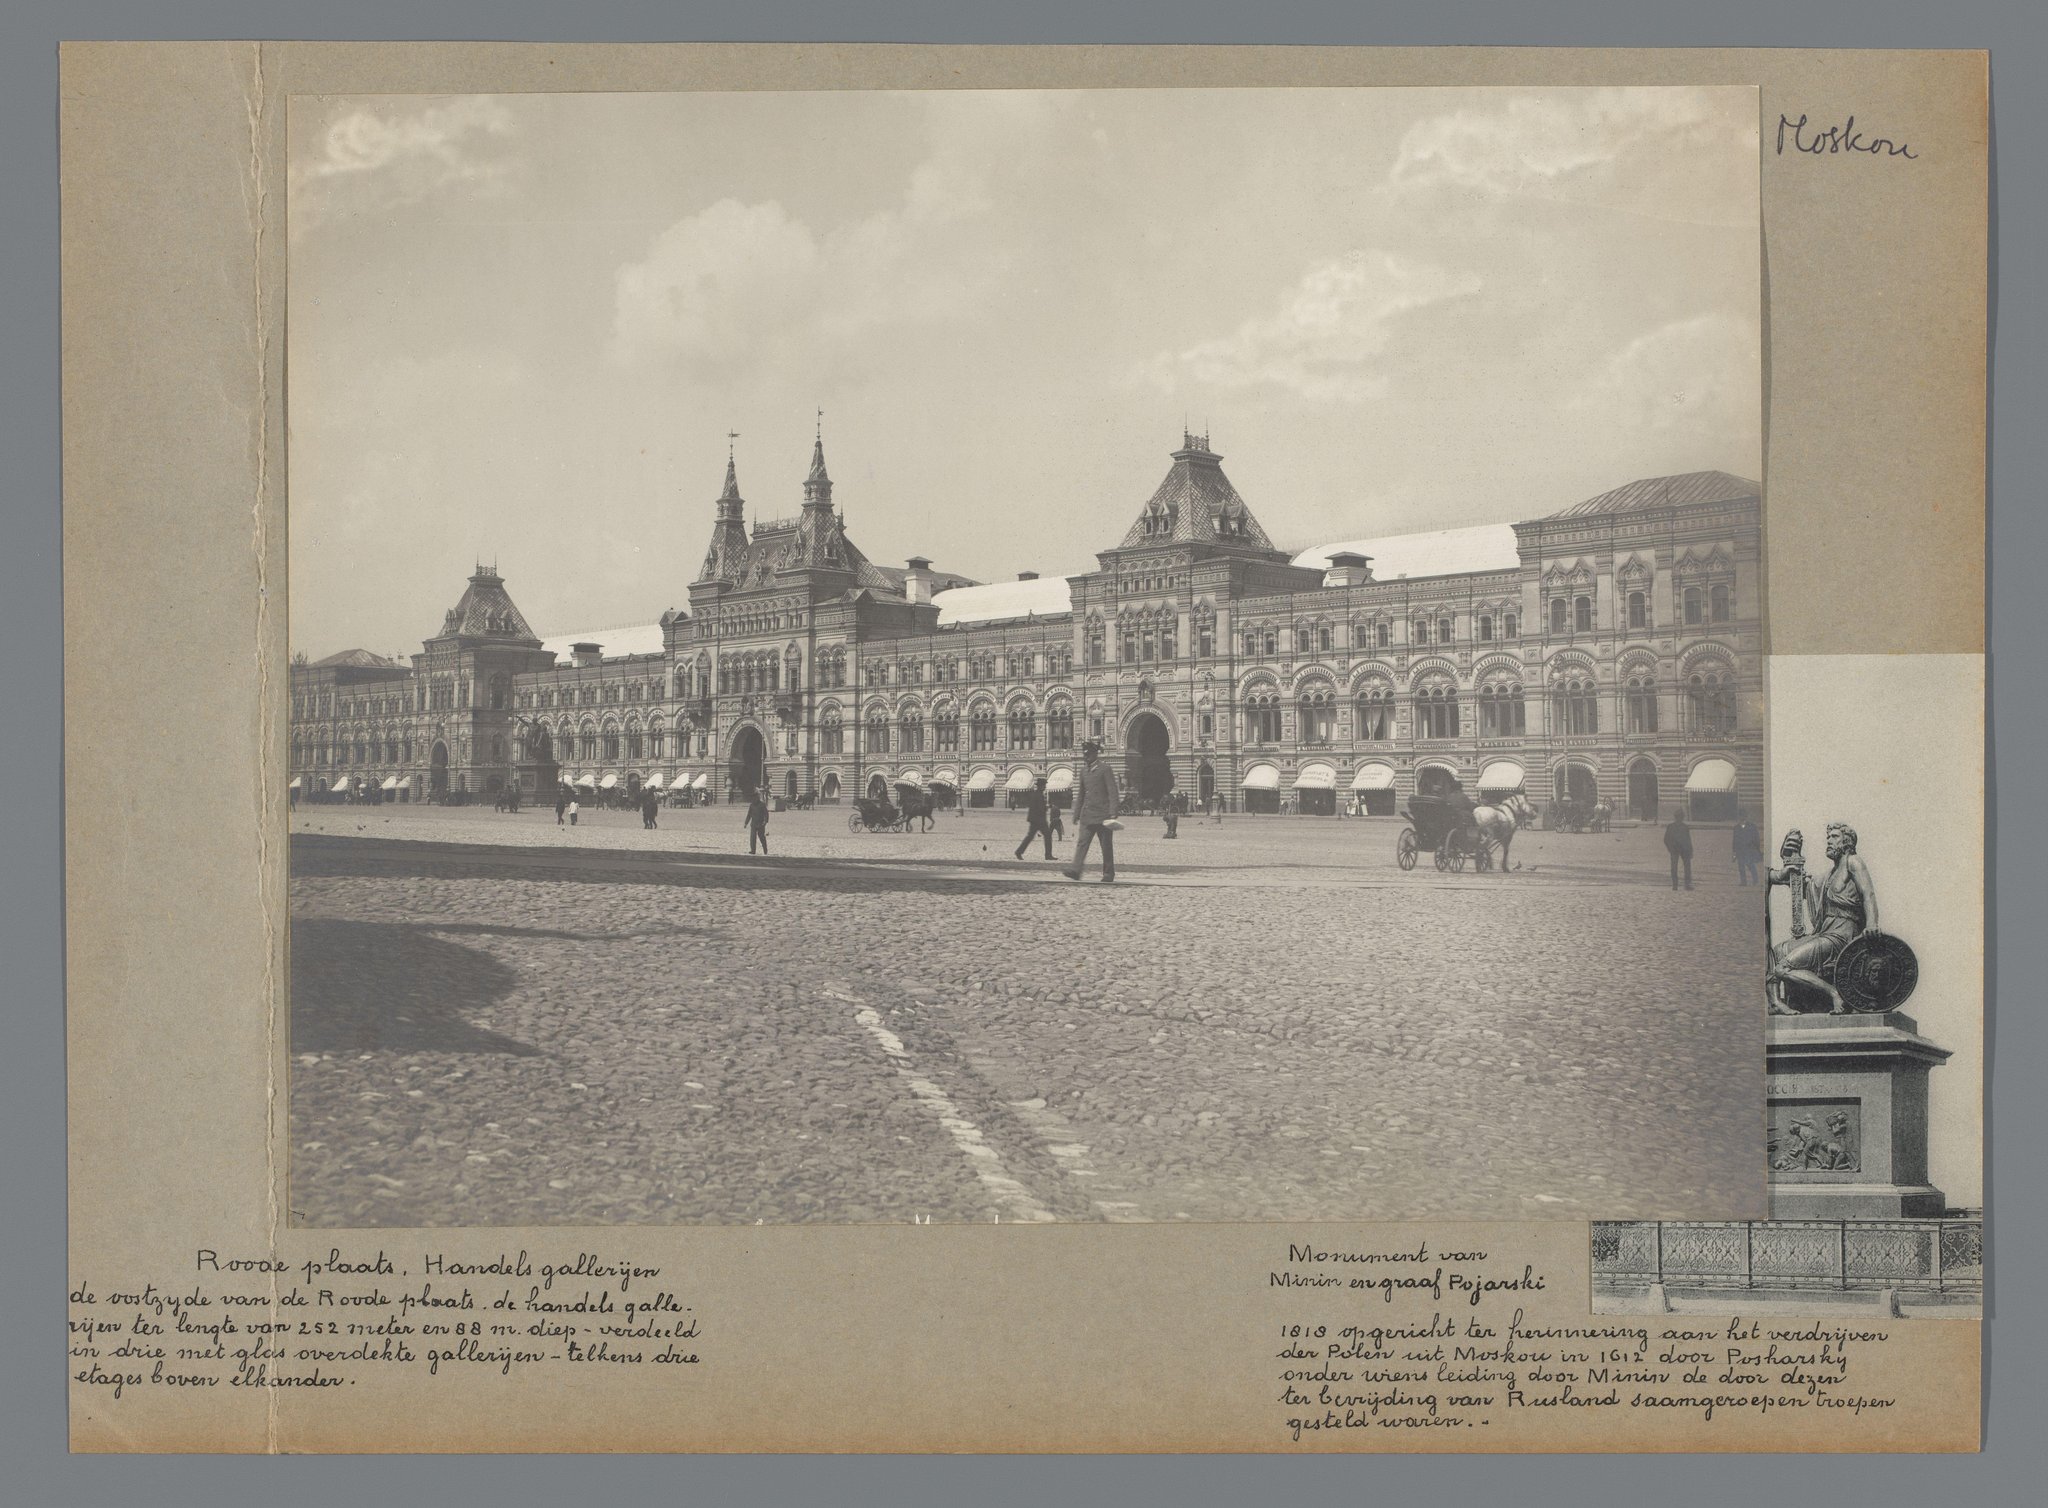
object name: photograph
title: Moskou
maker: Anonymous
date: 1880-1930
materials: photographic support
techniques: photograph, gelatin silver print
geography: russia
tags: moskou